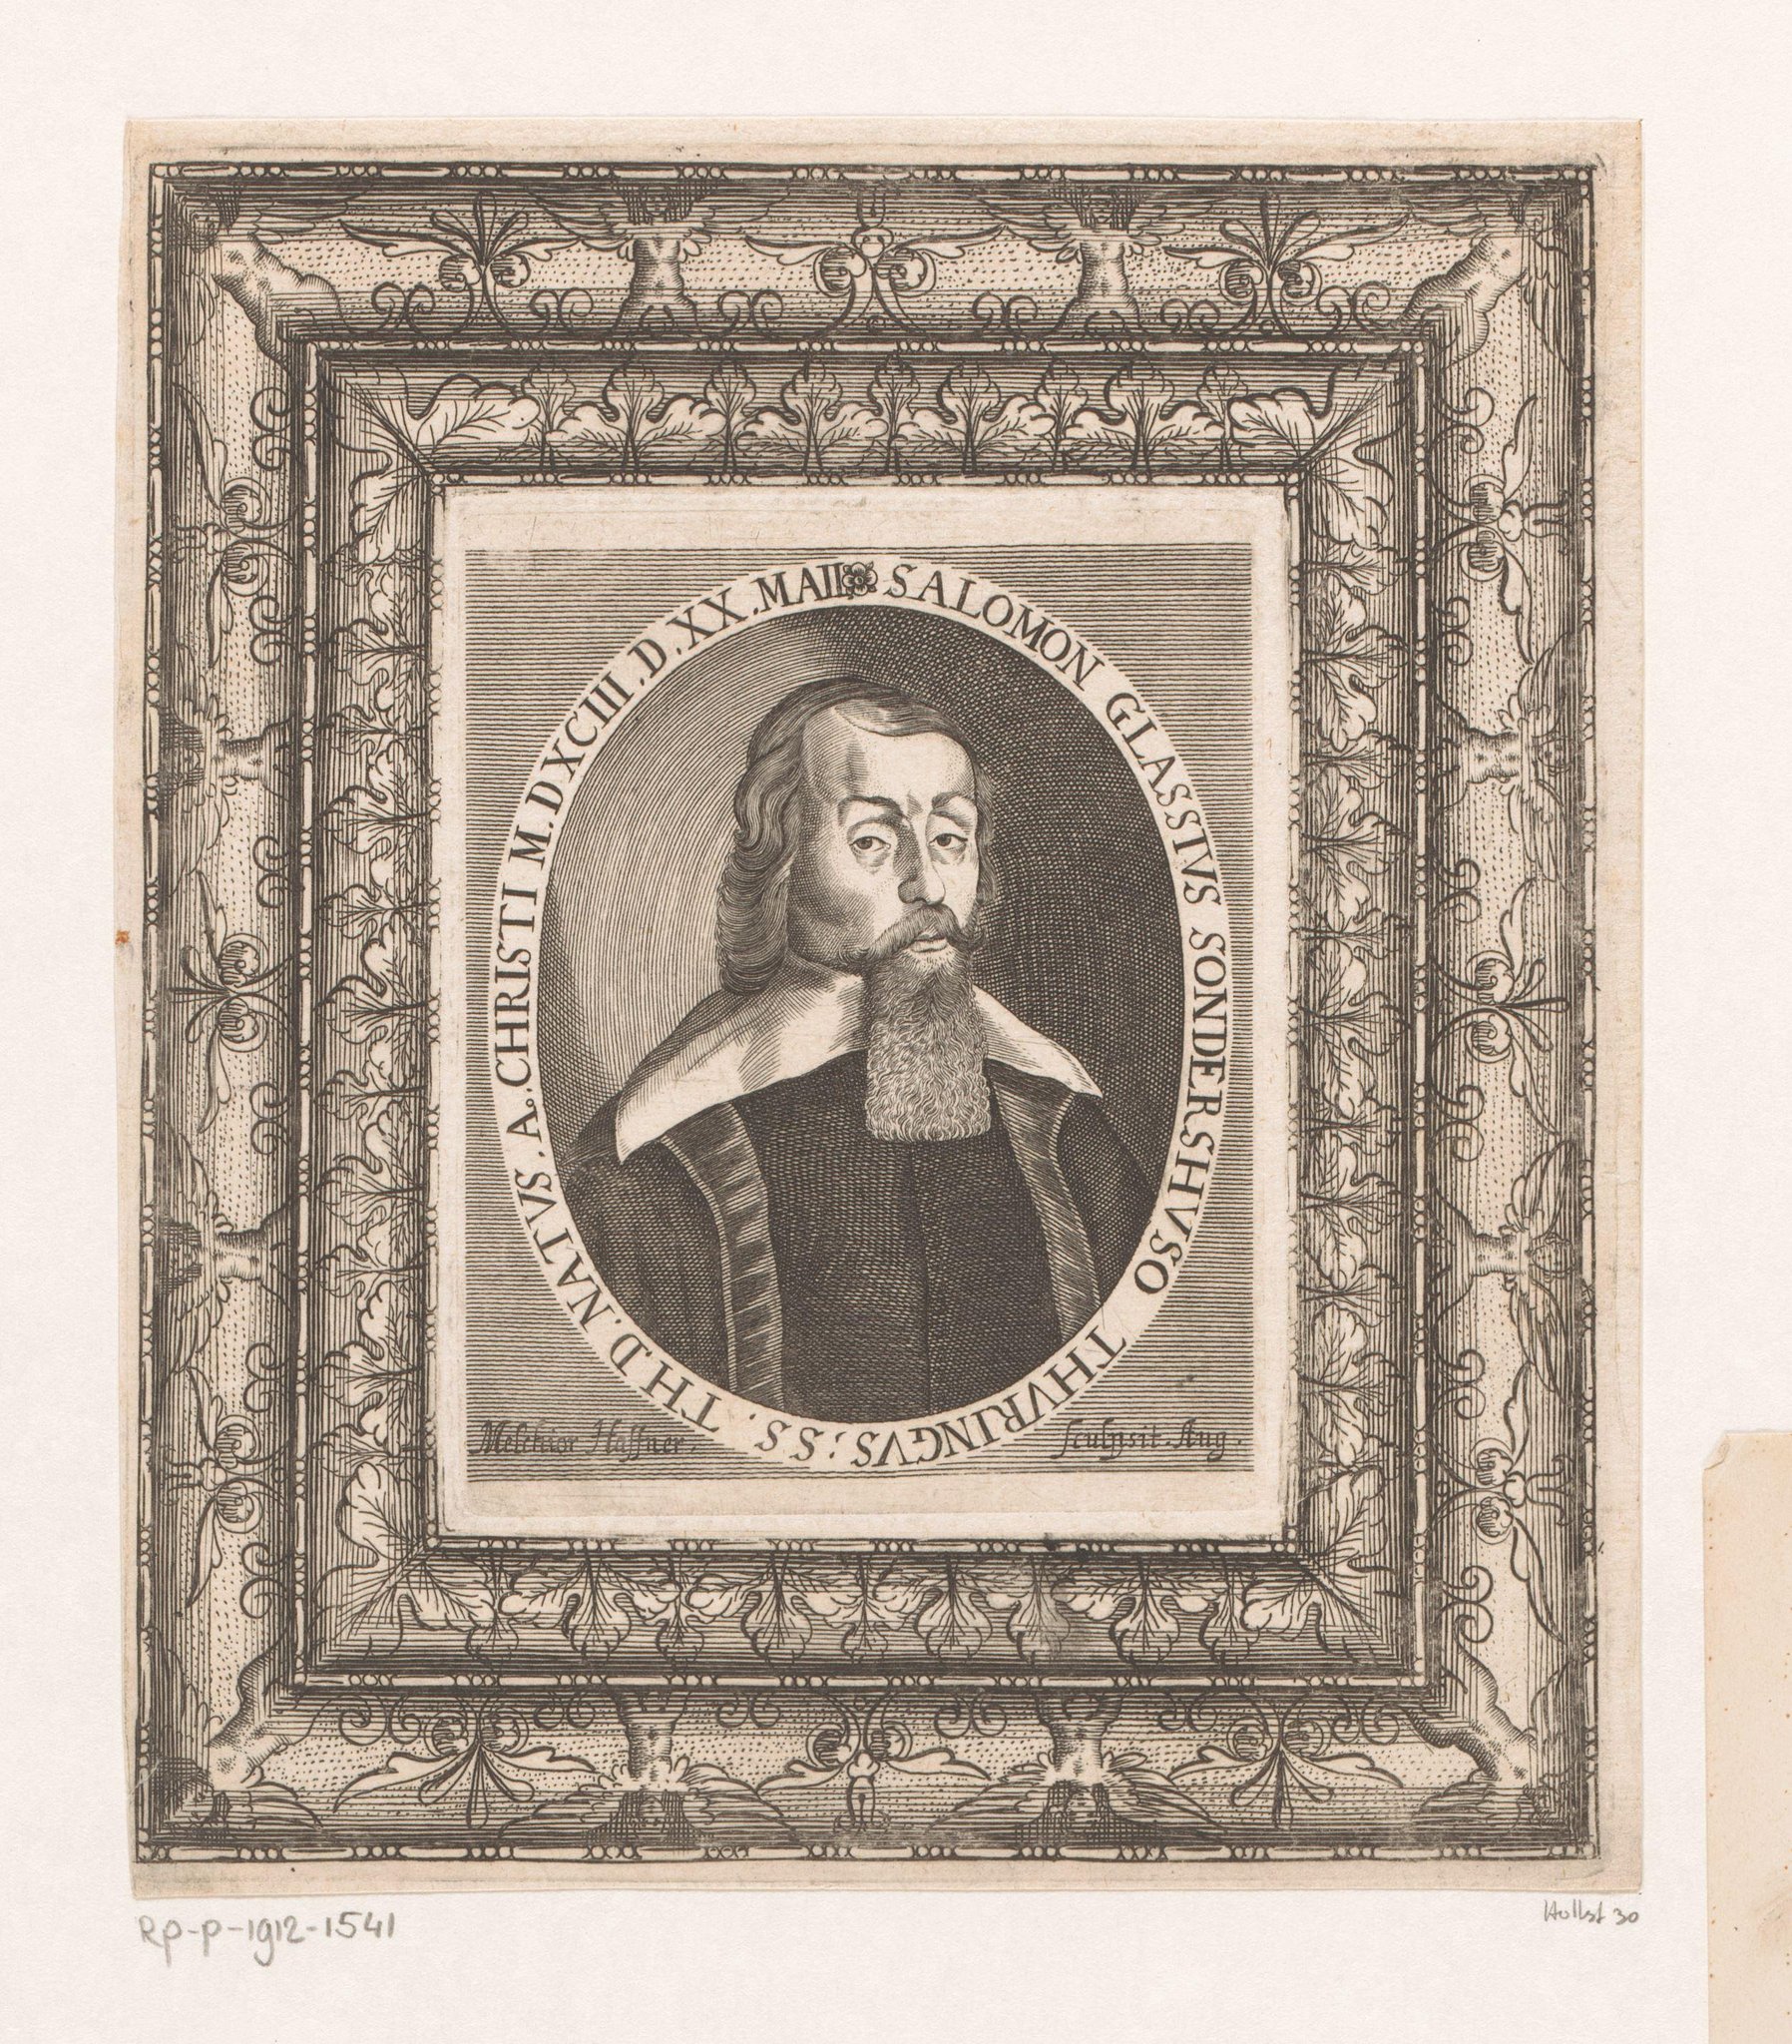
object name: print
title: Portret van Salomon Glass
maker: melchior hafner (ii)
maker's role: print maker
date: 1673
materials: paper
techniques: engraving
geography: augsburg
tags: cherubs, i.e. children's heads with wings, acanthus ~ ornament, theologian, historical persons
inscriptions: collector's mark: Lugt 2228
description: Prent gebruikt voor: Spizel, Gottlieb. Templum Honoris reseratum (...). Augsburg: Gottlieb Göbel, 1673.